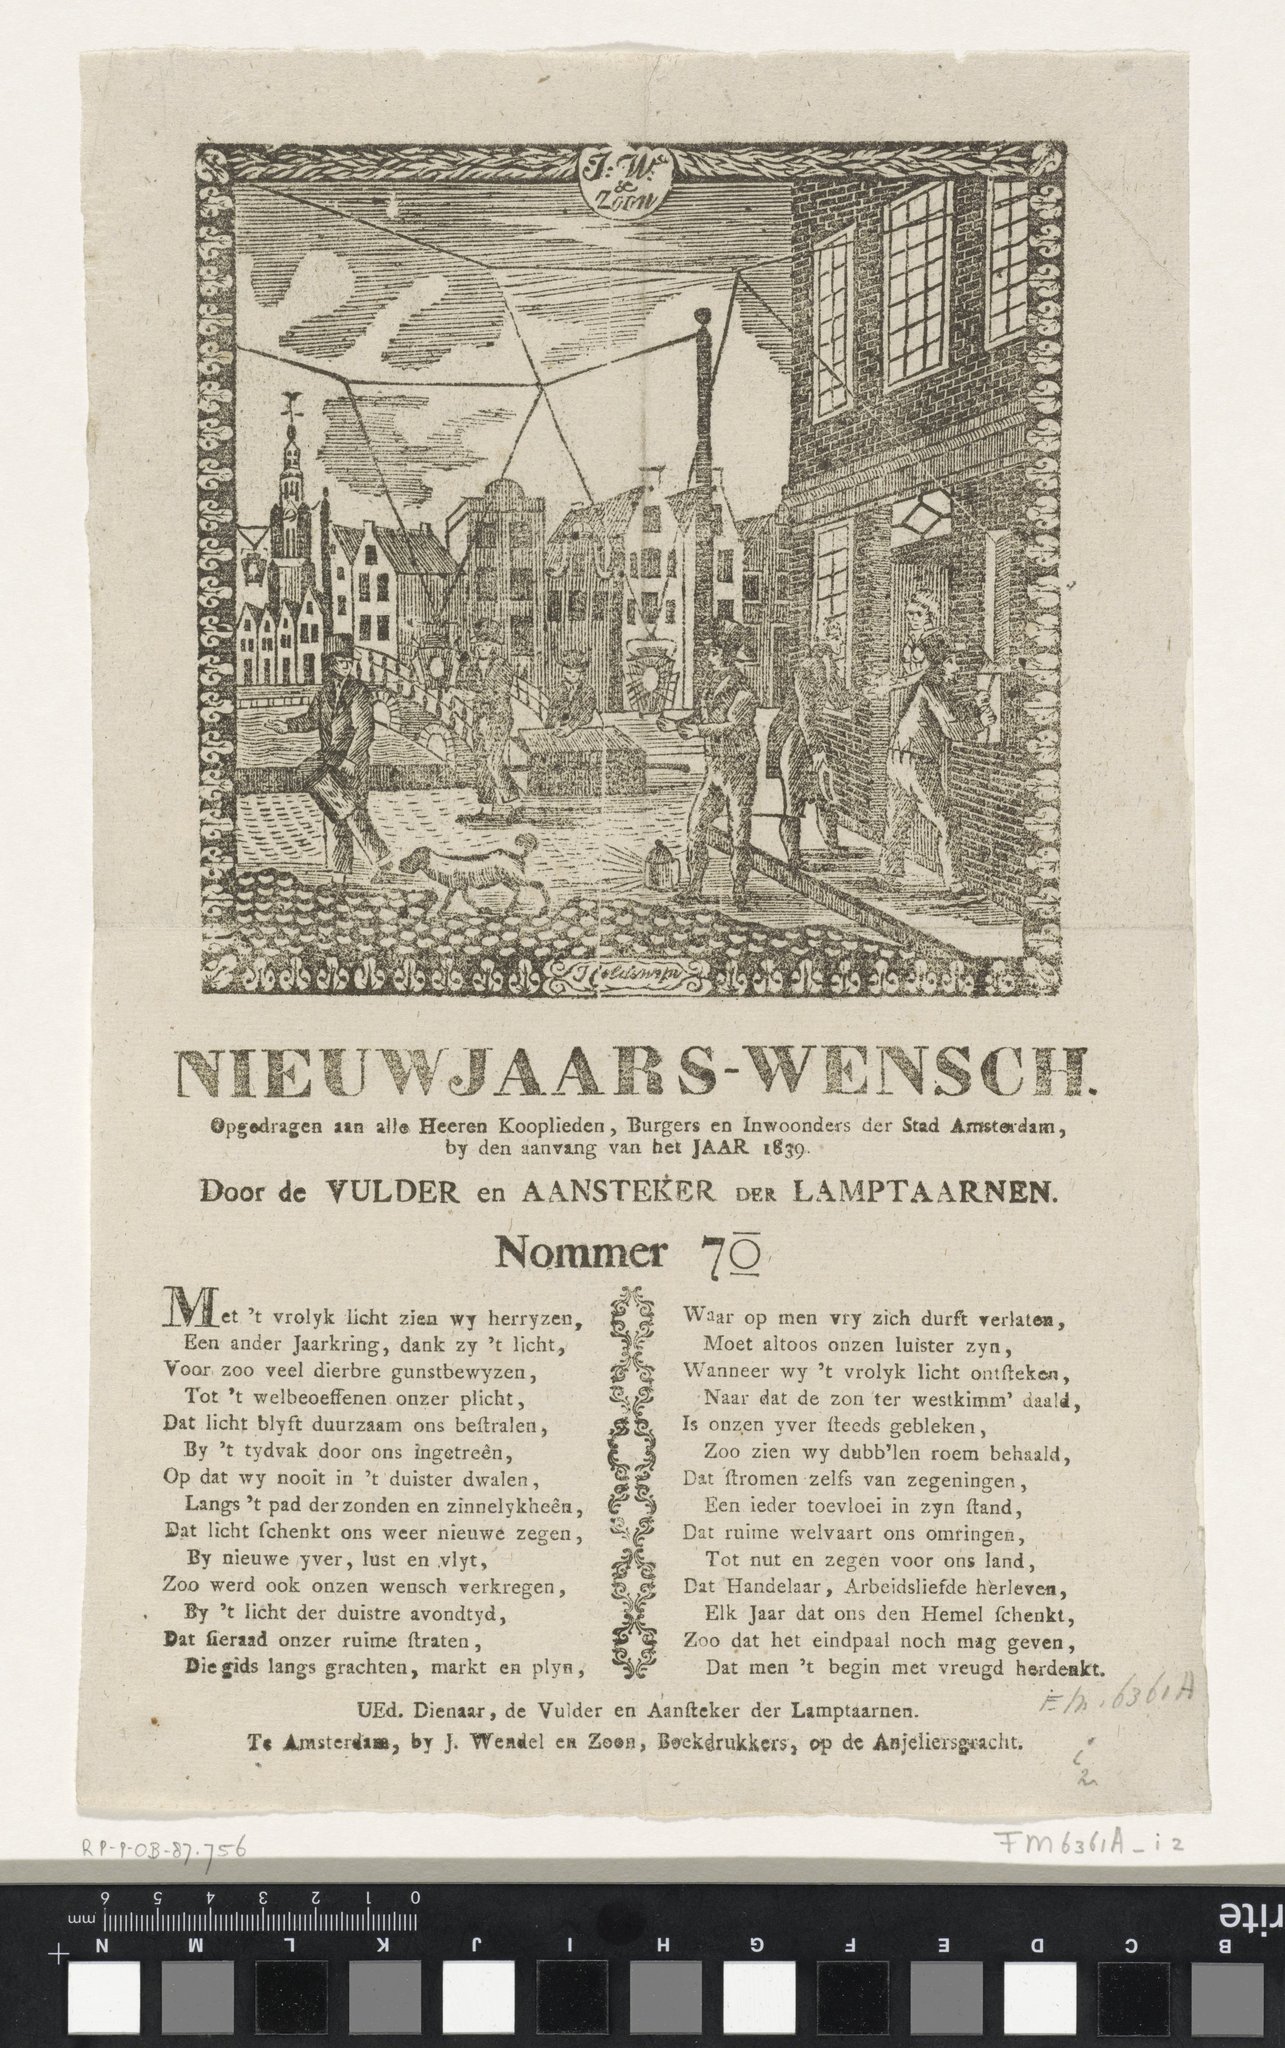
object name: print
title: Nieuwjaars-wensch. Door de Vulder en Aansteker der Lamptaarnen. Nommer 70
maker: jacob coldewijn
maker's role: print maker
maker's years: 1796-1855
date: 1838-1839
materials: paper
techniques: letterpress printing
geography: amsterdam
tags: oil-lamp (+ kindling a light; lit, burning light, lamp, candle), street lighting, street, amsterdam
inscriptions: collector's mark: Lugt 2228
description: Nieuwjaarswens van de Amsterdamse lantaarnopstekers en vullers voor het jaar 1839. Gezicht in een straat in Amsterdam waar enkele mannen bezig zijn de straatlantaarns te vullen en aan te steken. Een andere man haalt geld op bij een huis. Met gedicht in twee kolommen. Van de lantaarnopstekers in de wijk no. 70.